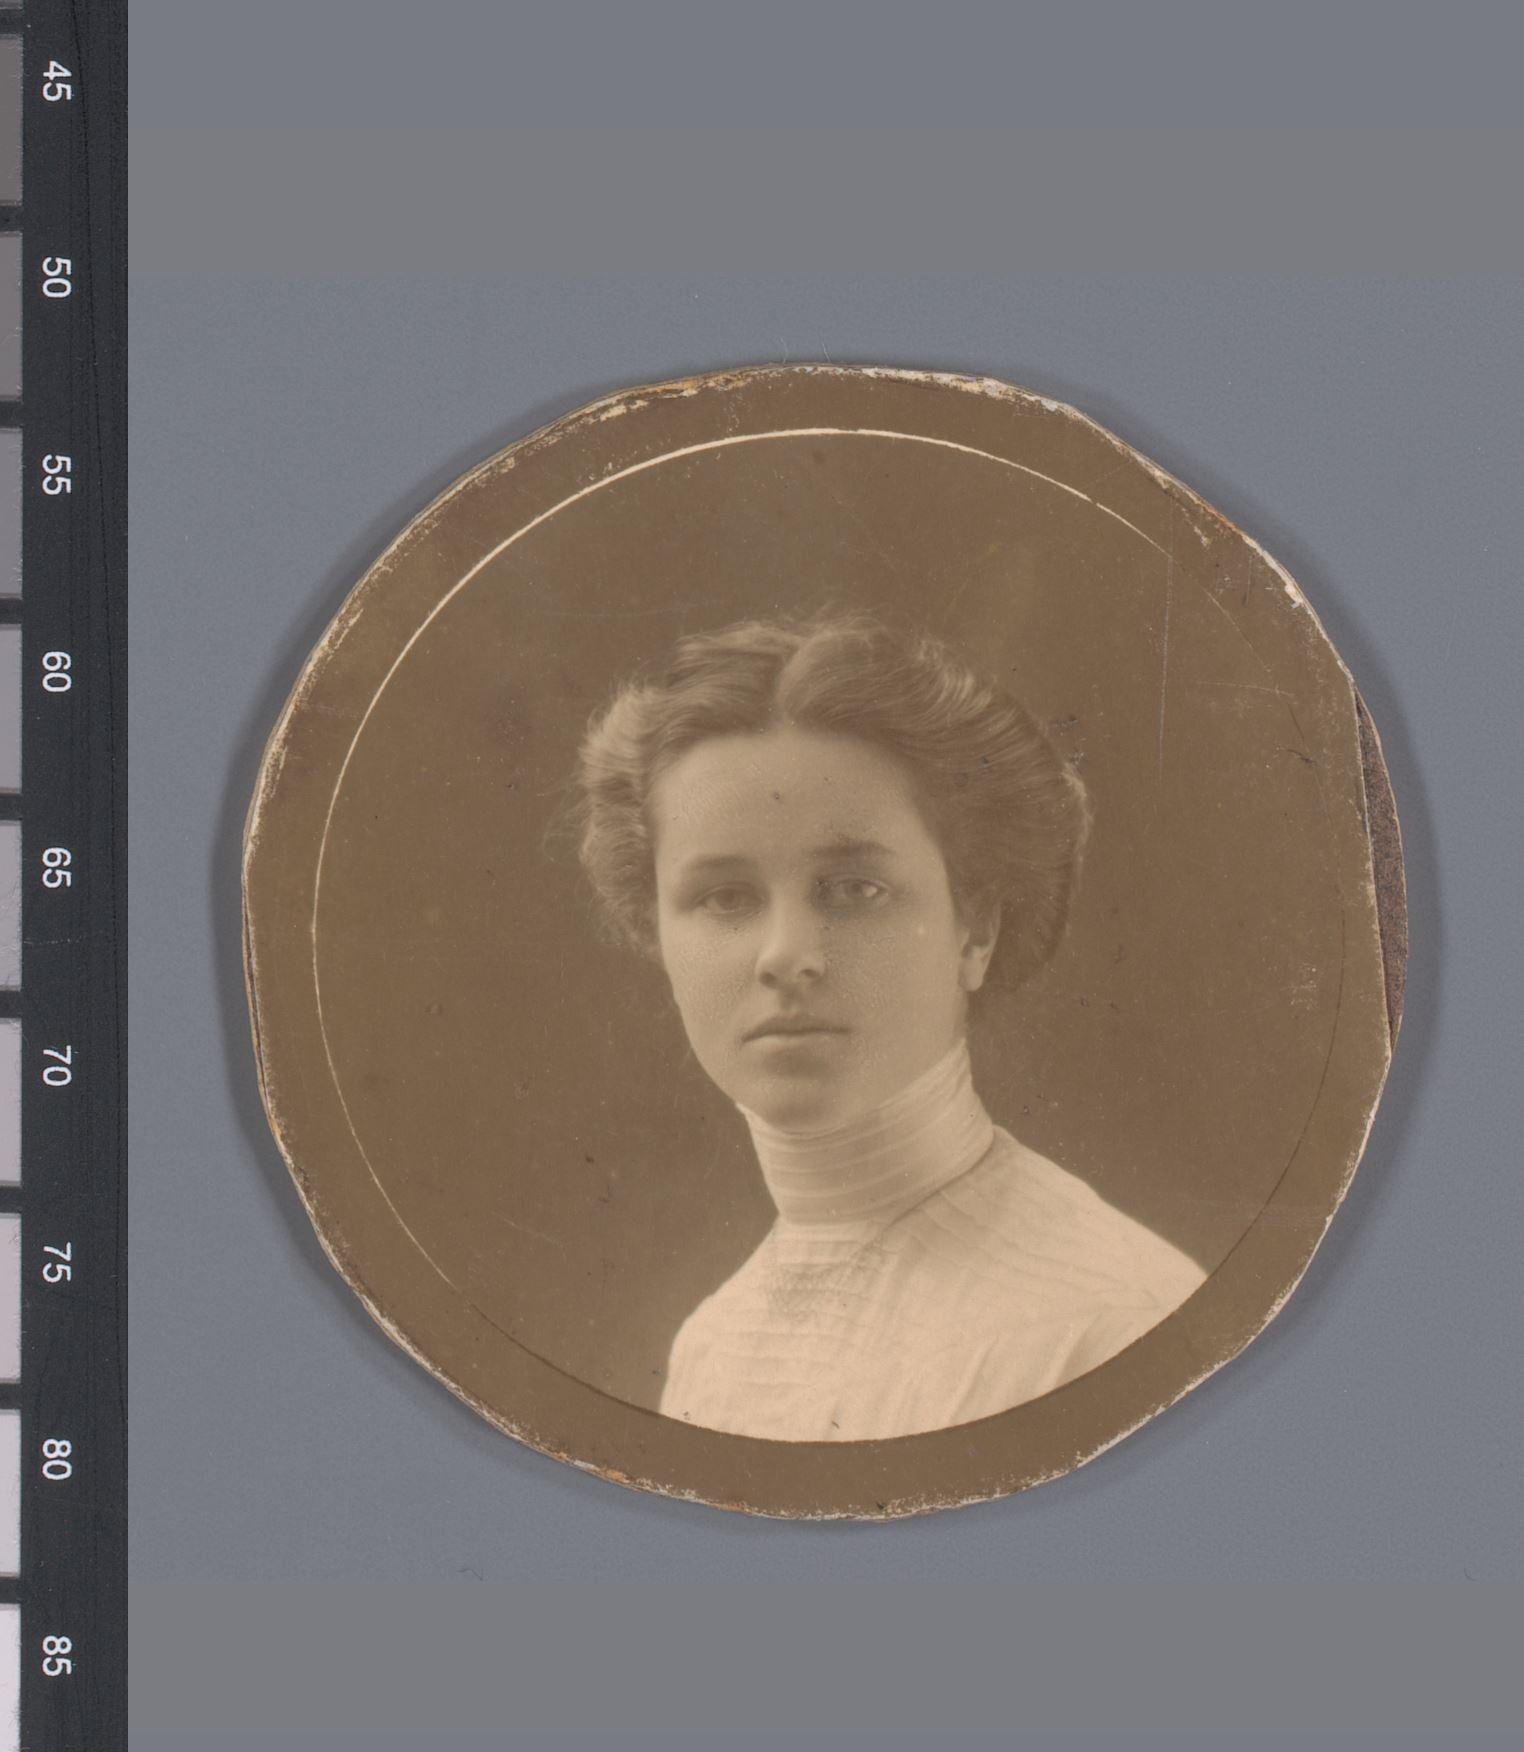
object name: photograph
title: Portret van Johanna Geertruida Jonker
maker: franz eiffert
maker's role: fotograaf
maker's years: 1866-1929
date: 1911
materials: cardboard, photographic support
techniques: collodion silver print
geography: amsterdam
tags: historical persons, amsterdam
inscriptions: annotation: ‘[...] 1911’